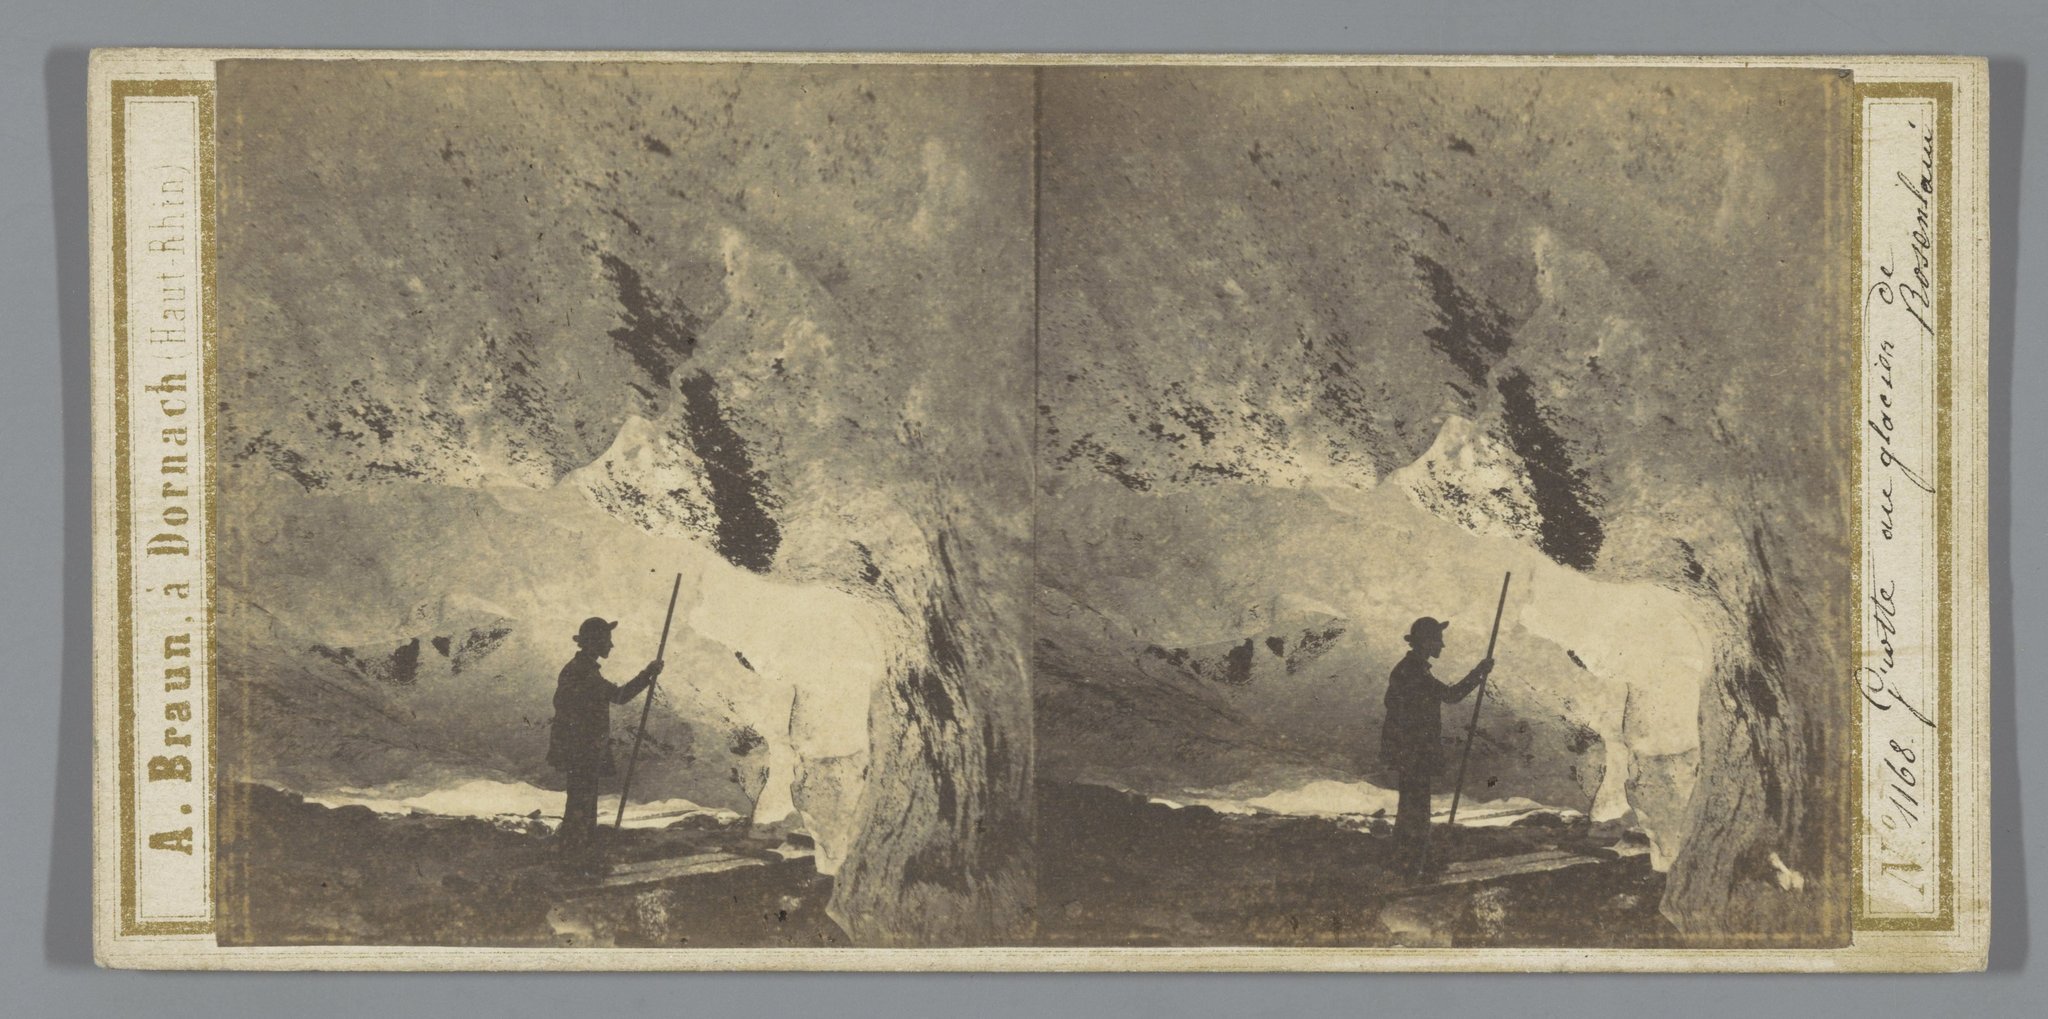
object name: stereograph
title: Man in een grot onder de Rosenlauigletsjer, Zwitserland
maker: Anonymous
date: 1860-1866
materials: cardboard, paper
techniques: albumen print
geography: dornach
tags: cave, grotto, glacier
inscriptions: inscription: ‘Heseleskamp [?]’, number: ‘No. 1168.’